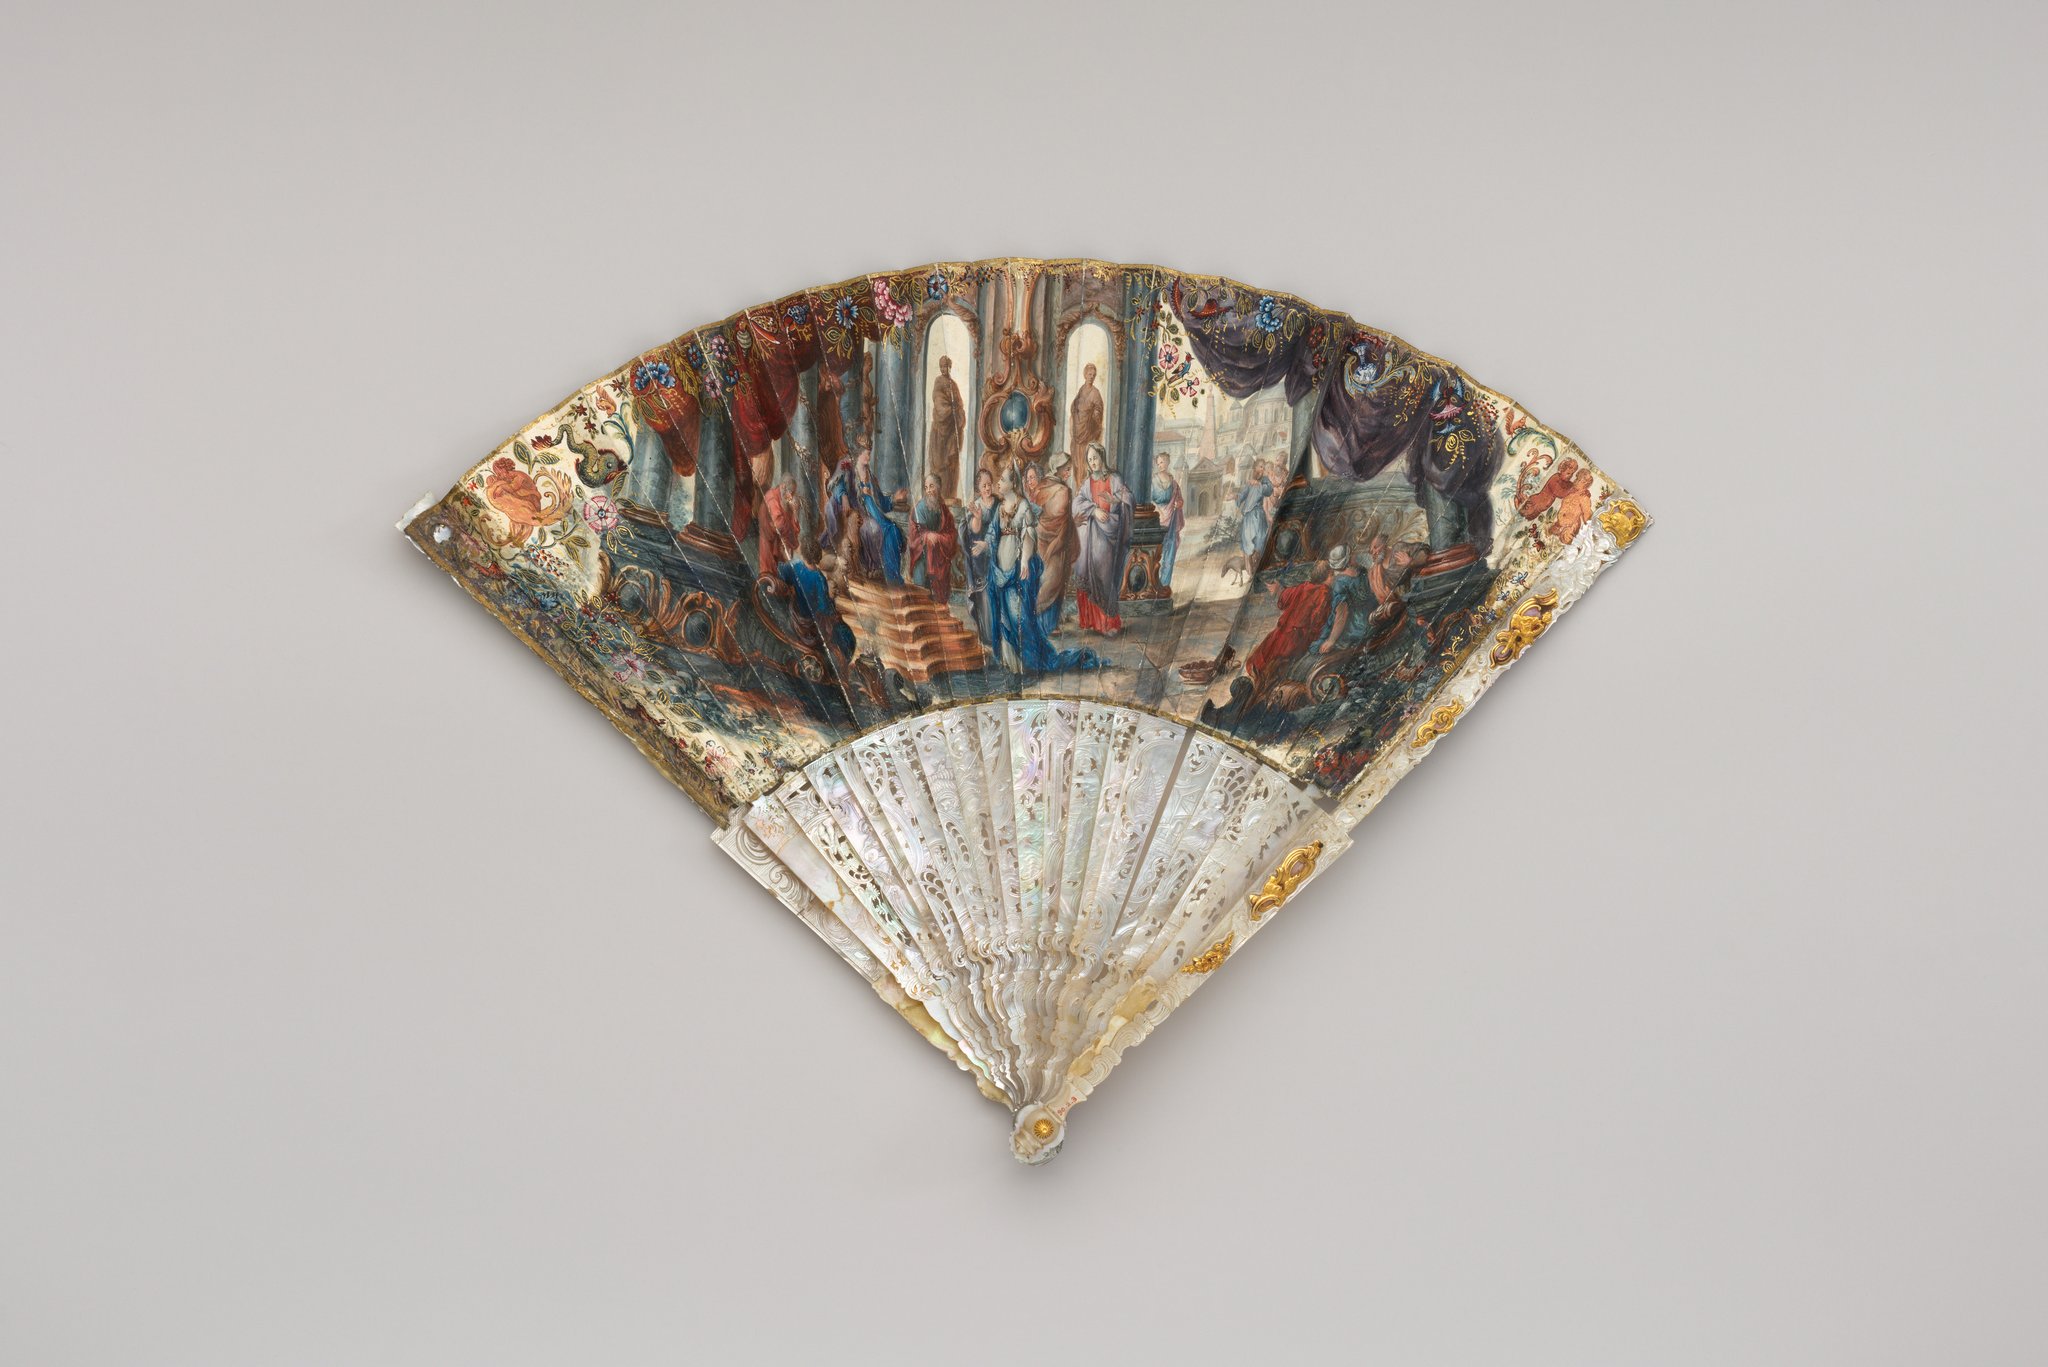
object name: fan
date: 1700-1723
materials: gold, mother of pearl, paint, parchment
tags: men,women